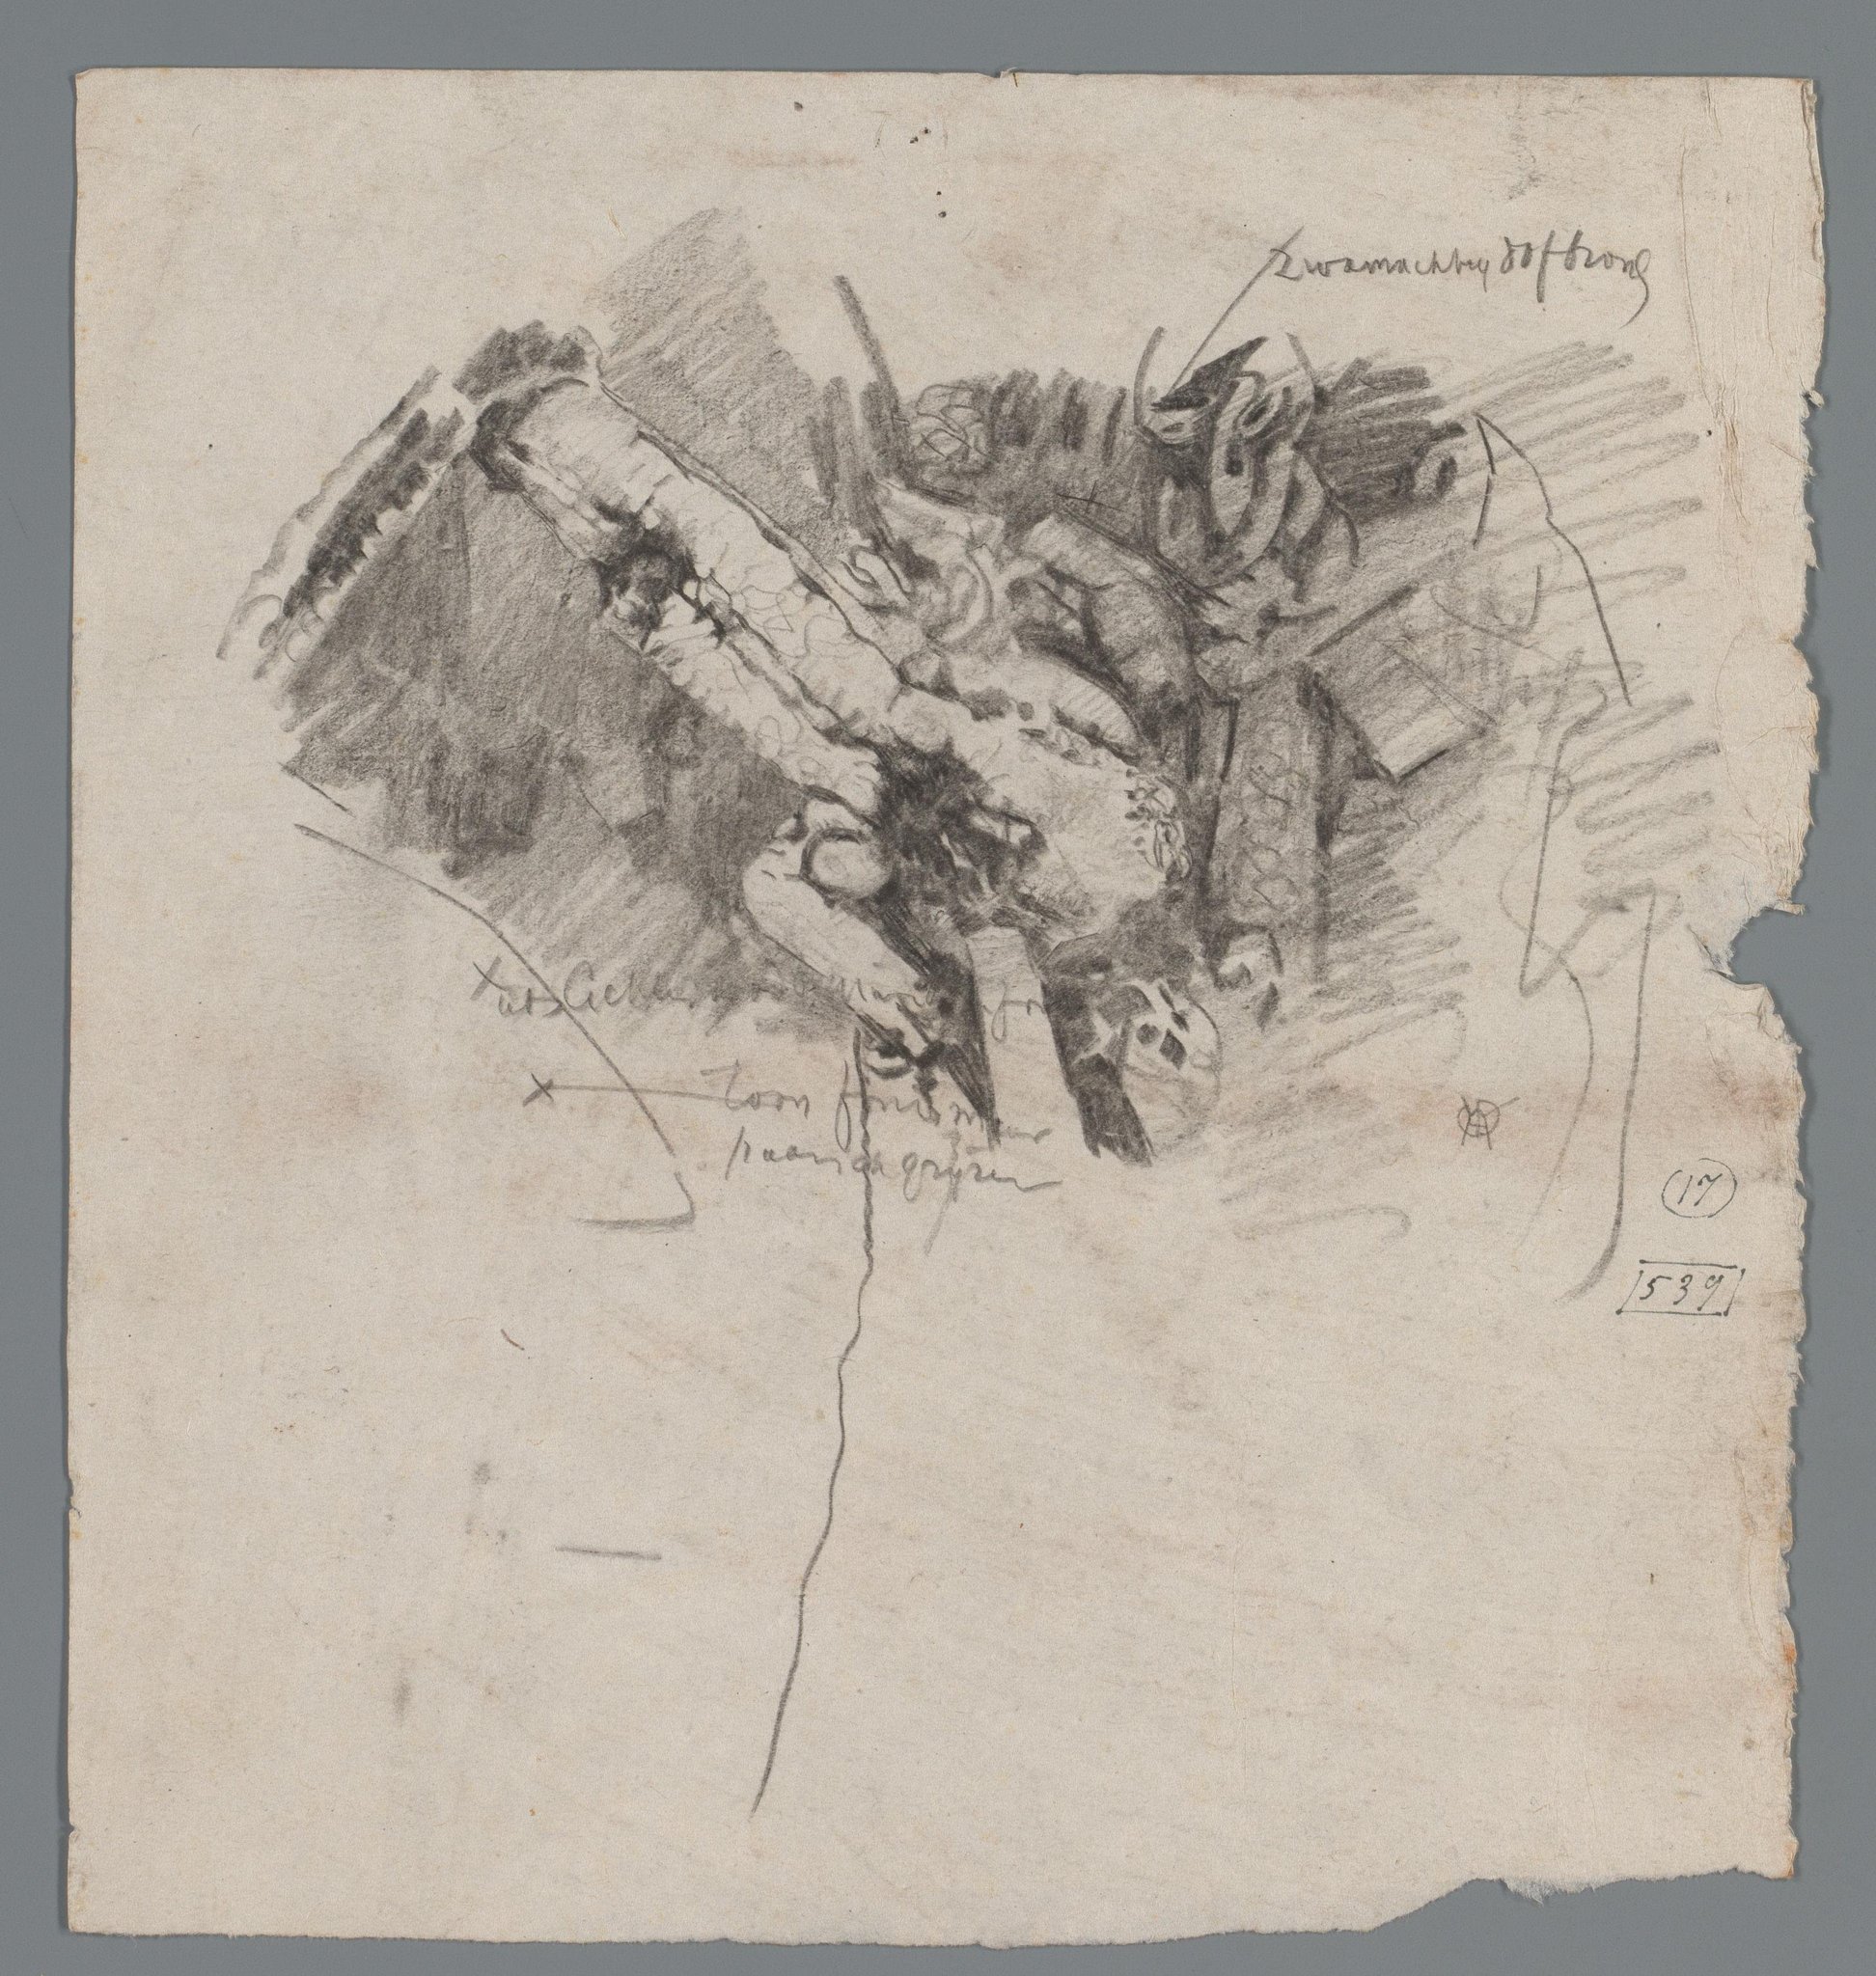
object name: drawing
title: Studie van aquarium decoratie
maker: gerrit willem dijsselhof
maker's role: designer, draughtsman, print maker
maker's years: 1866-1924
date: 1876-1924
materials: chalk, paper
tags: aquarium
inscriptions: number: ‘539’, number: ‘17’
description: Met aantekeningen en met op verso een schets met lijnen en afmetingen.